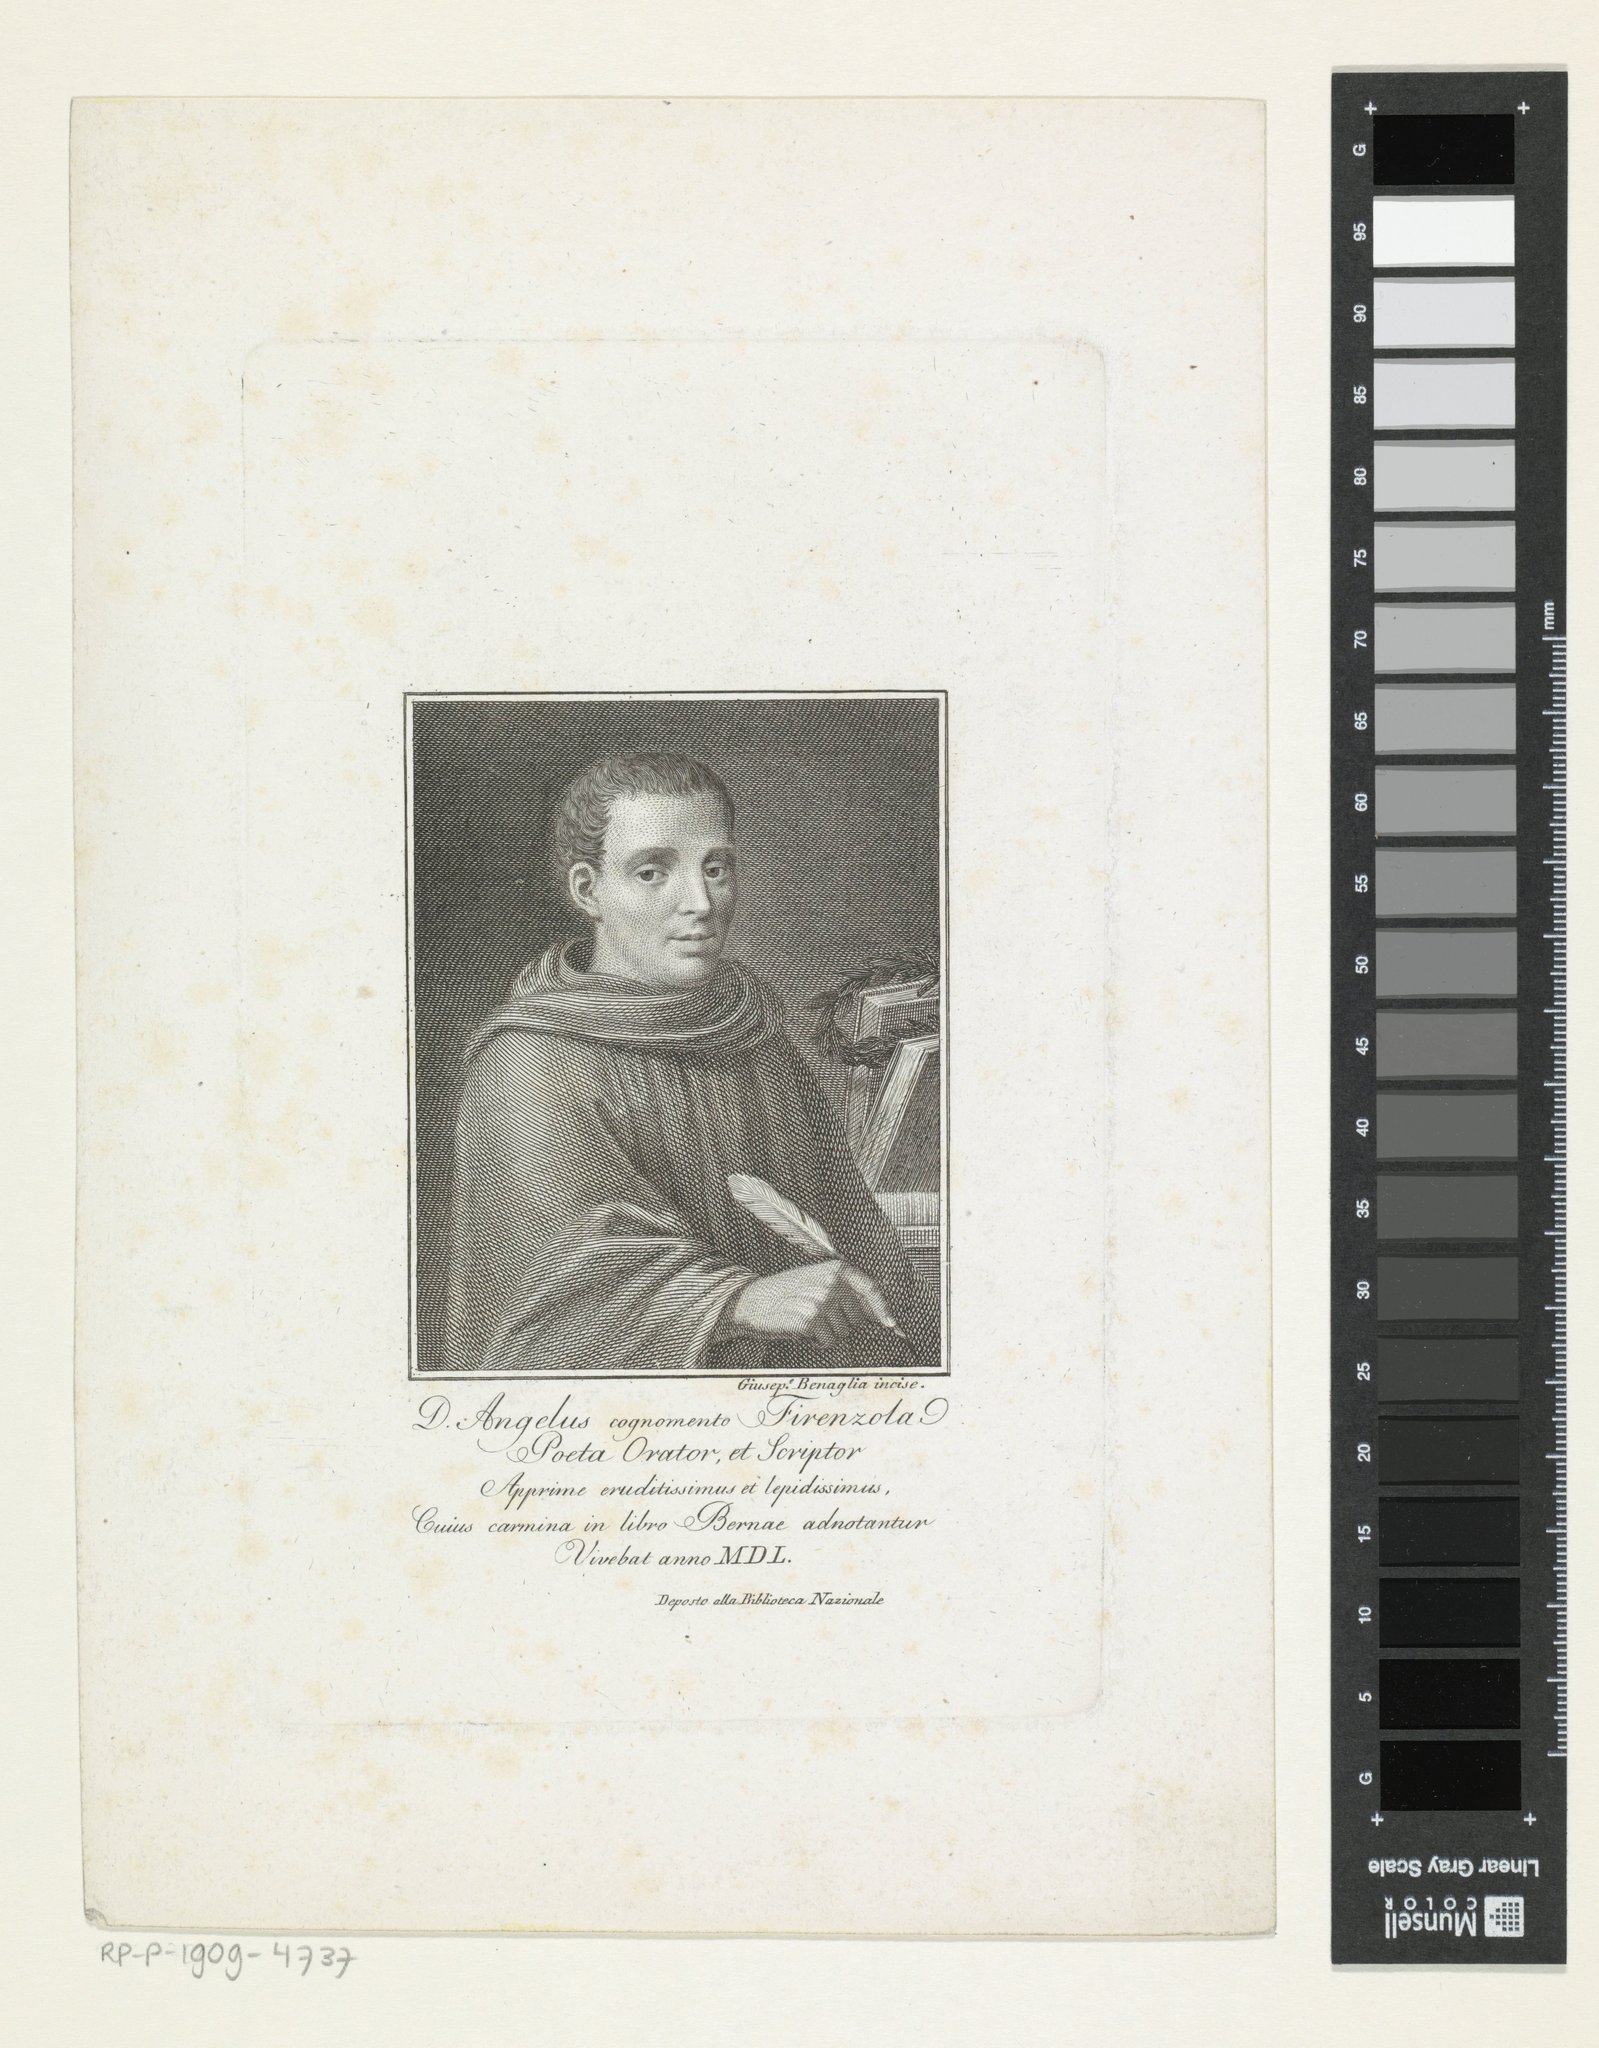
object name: print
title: Portret van dichter en schrijver D. Angelus met schrijfveer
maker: giuseppe benaglia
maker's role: print maker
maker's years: 1796-1830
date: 1806-1830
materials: paper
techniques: engraving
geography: italy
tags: historical persons, portrait of a writer, writer, poet, author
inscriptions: collector's mark: Lugt 2228